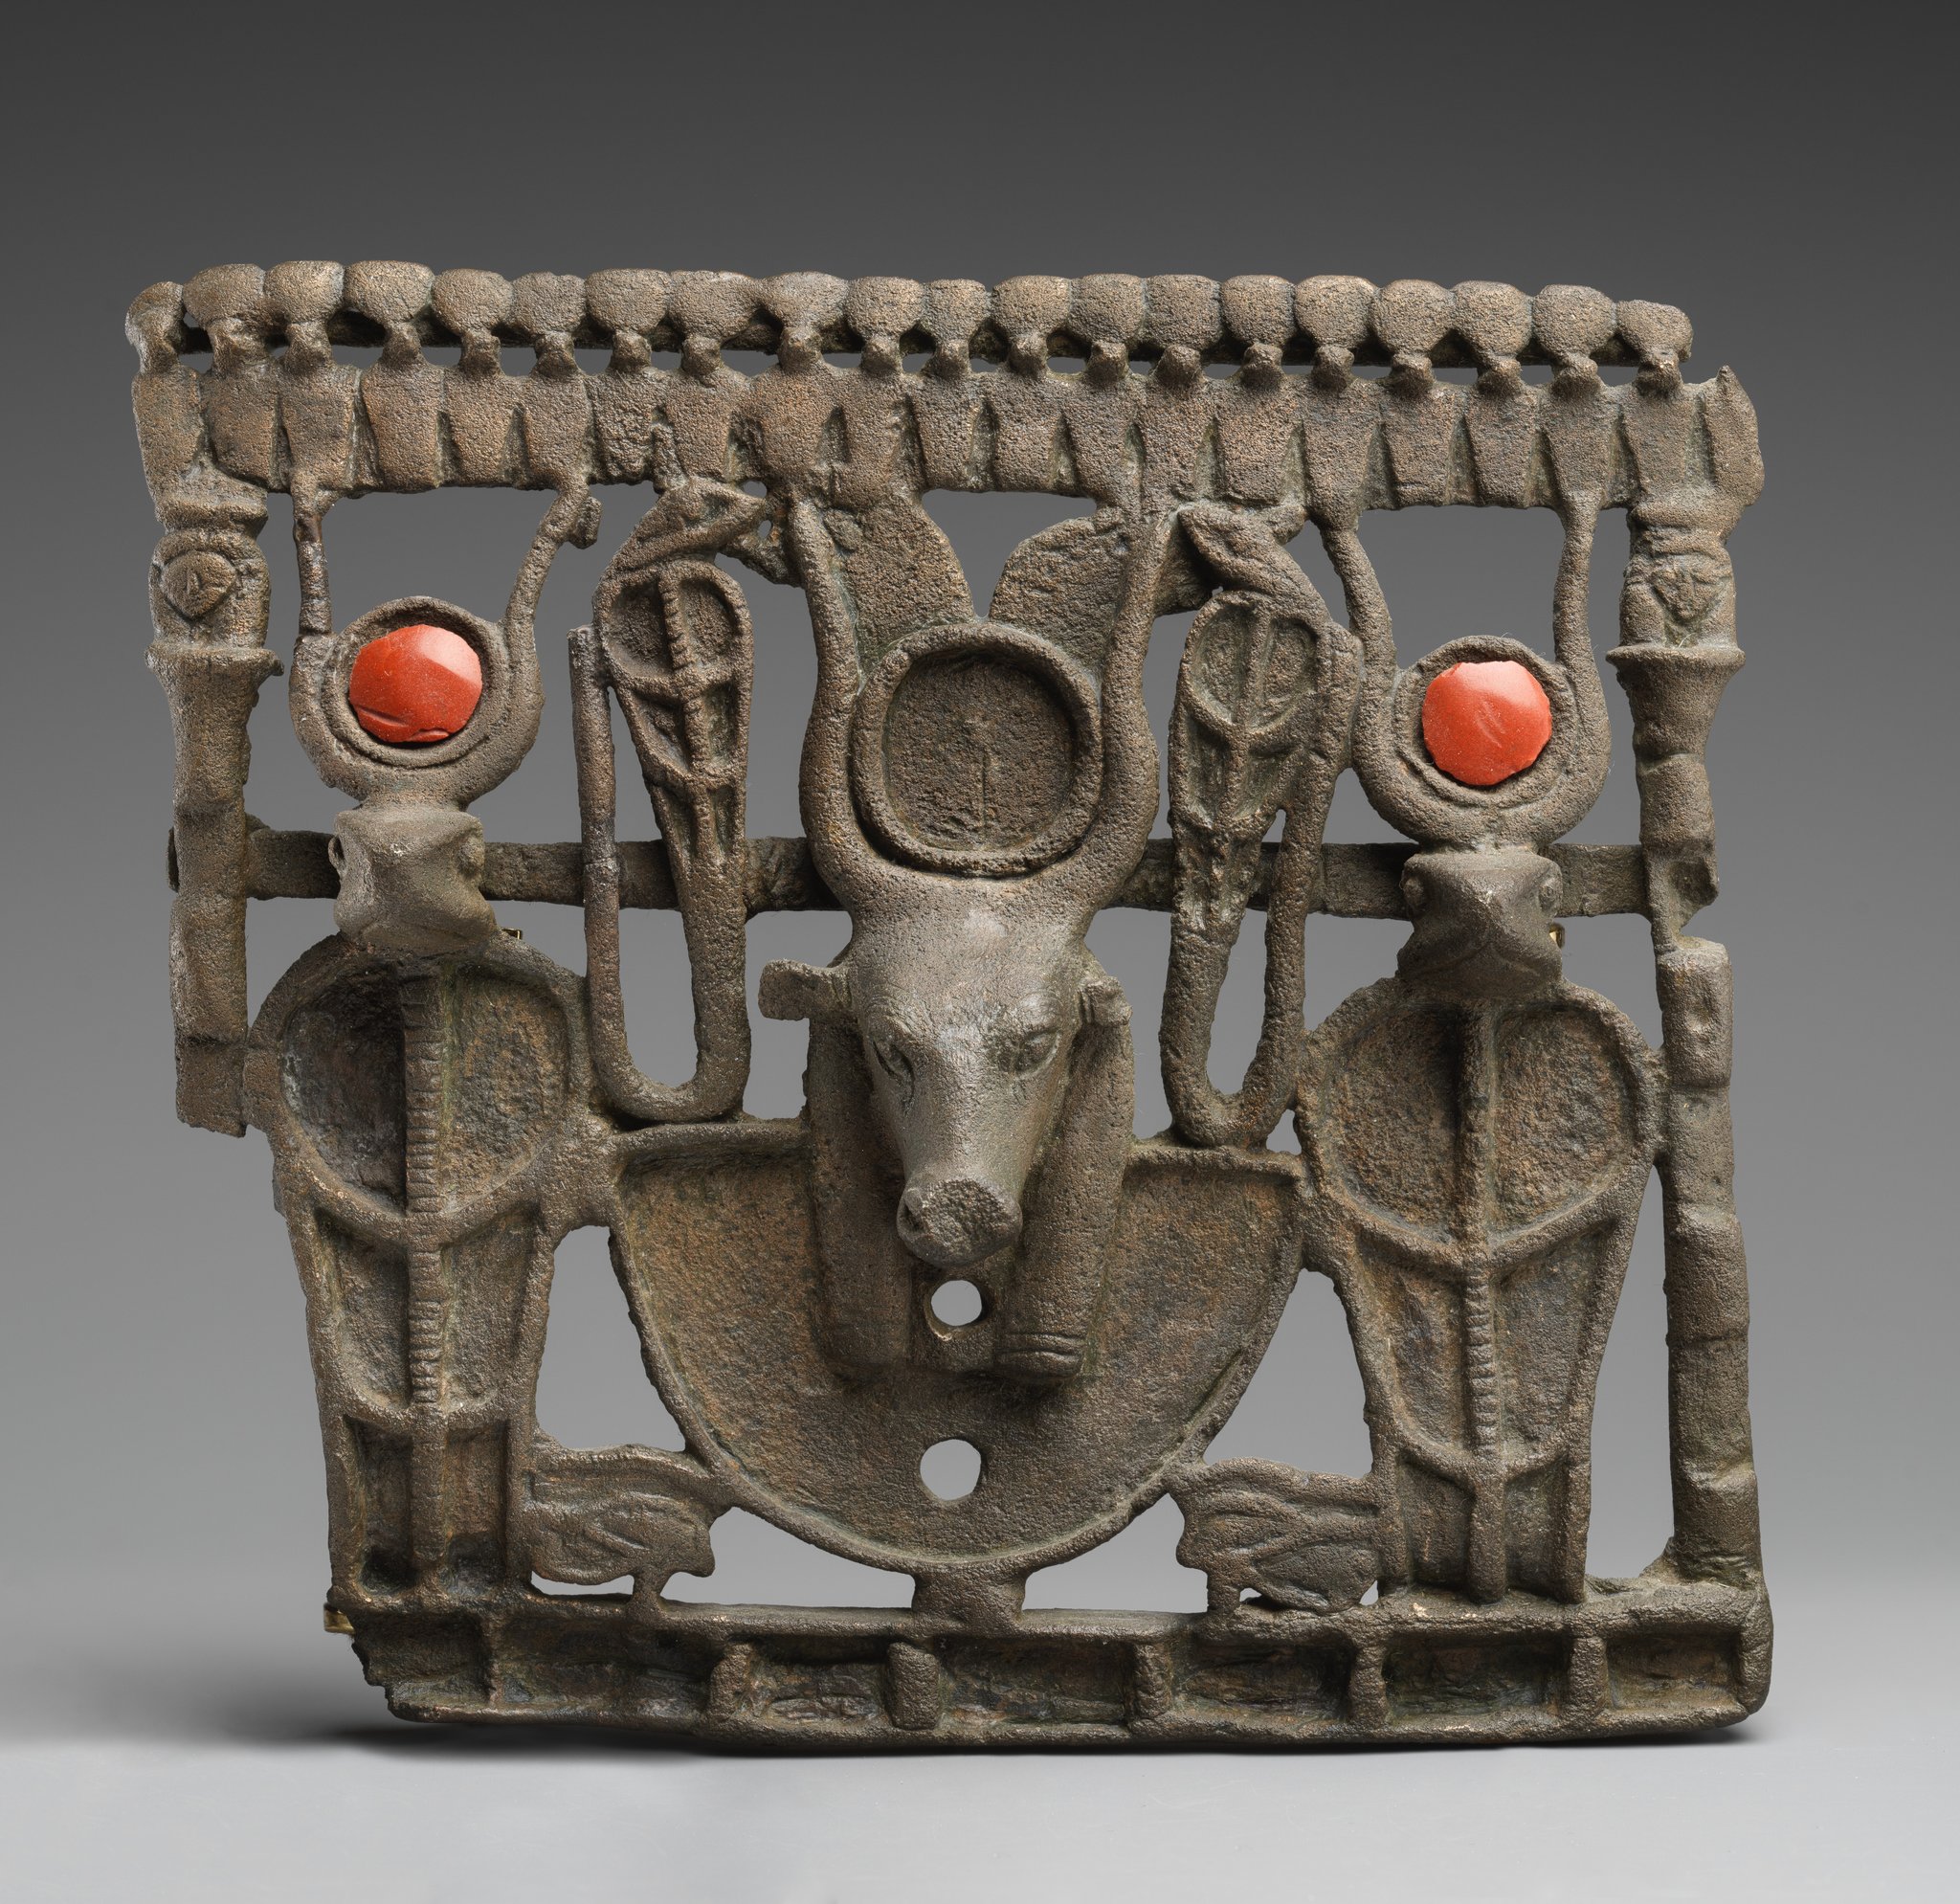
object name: pectoral, bovine headed god, apis, mother of apis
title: Pectoral with bovine head crowned with disk, horns and feathers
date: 664-200 BCE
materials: gemstone, metal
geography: egypt